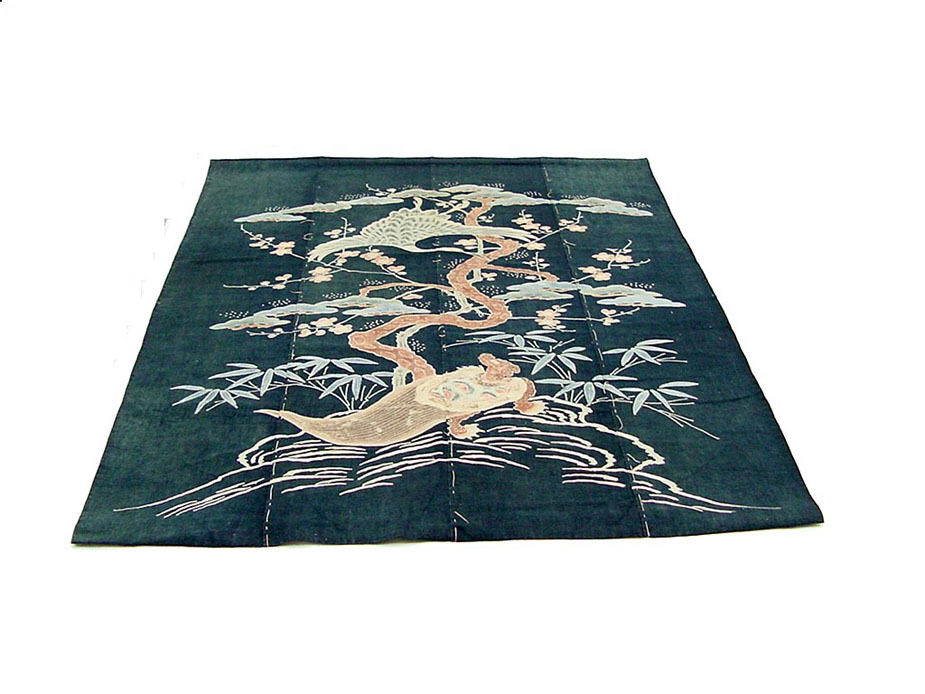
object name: futon cover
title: Futon Cover with Turtle, Crane, Pine, Plum, and Bamboo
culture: japanese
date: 1801-1900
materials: cotton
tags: cranes,turtles,bamboo,trees